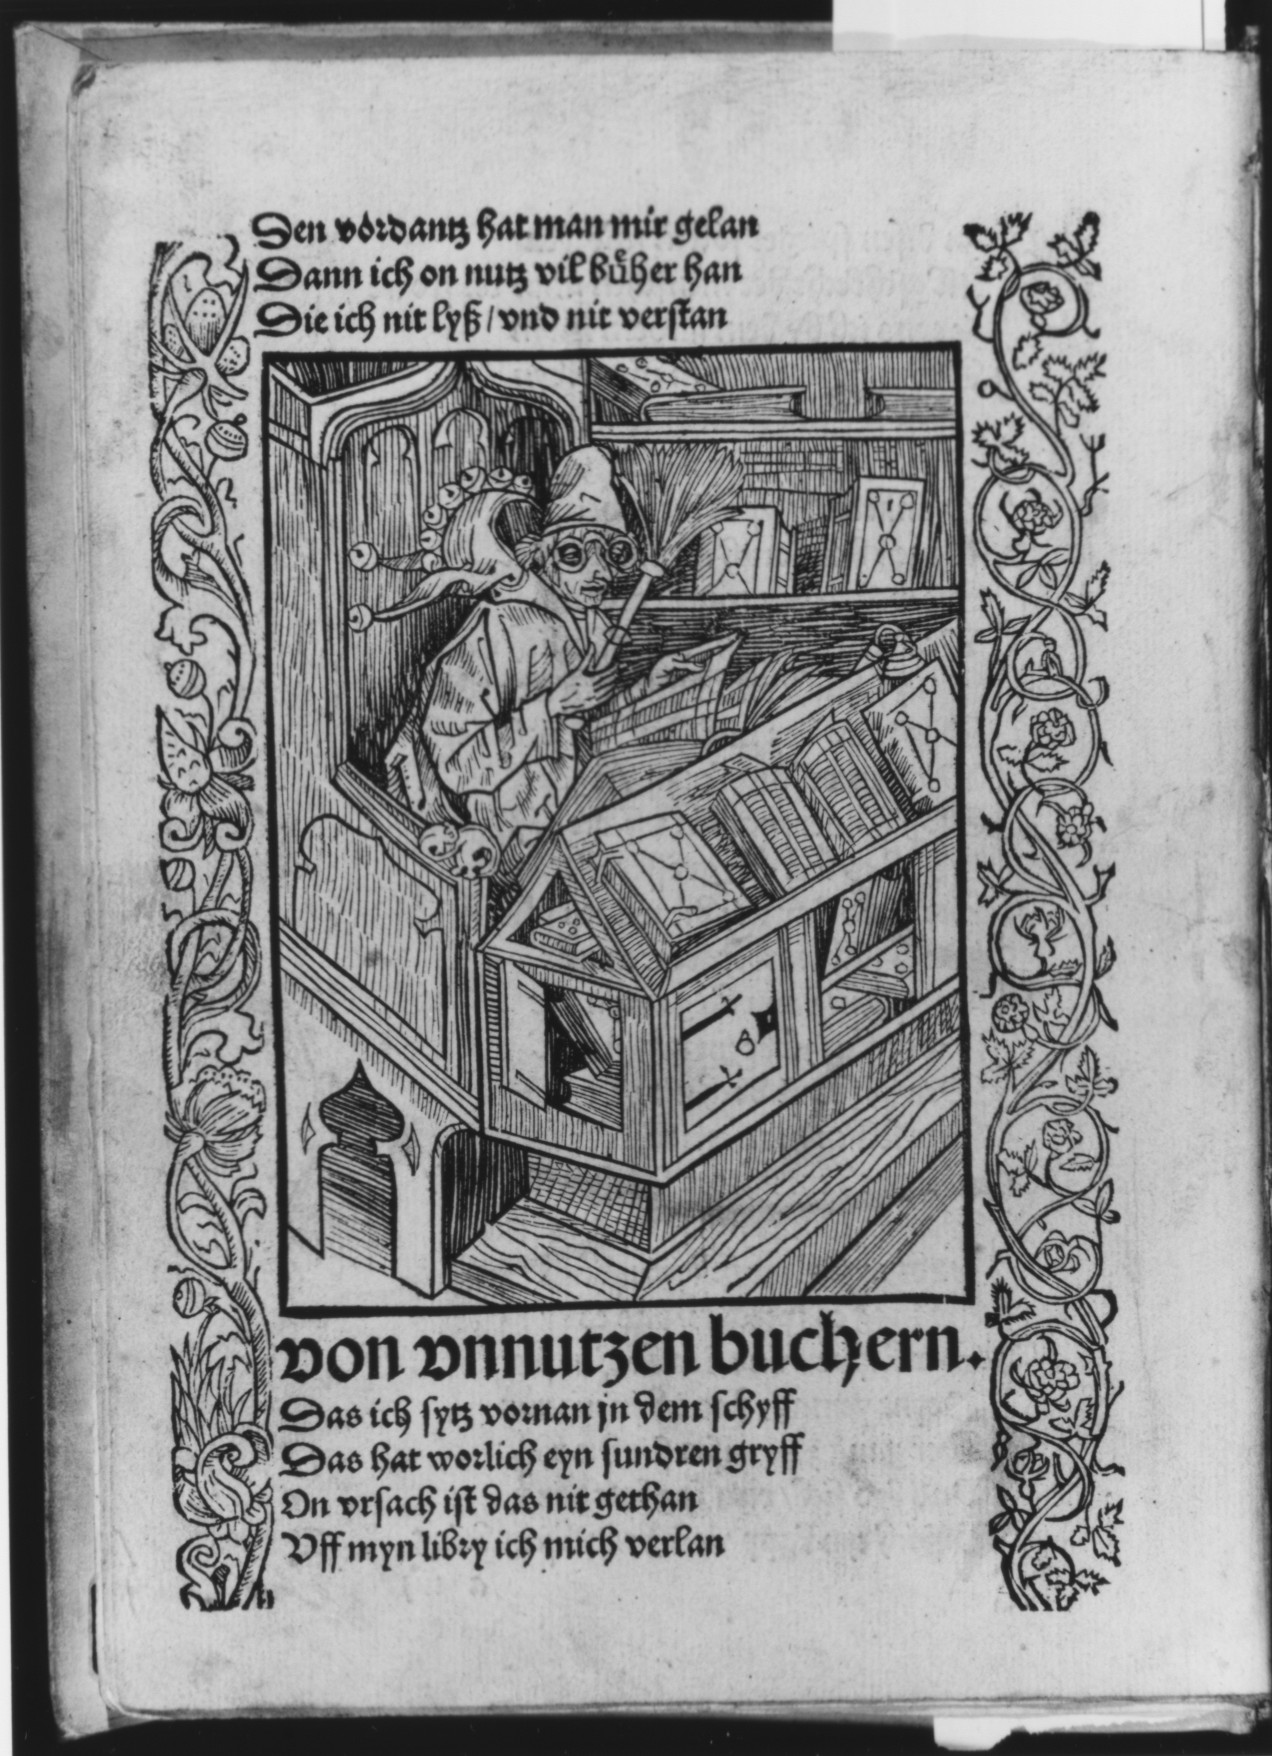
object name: book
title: Das Narrenschyff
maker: albrecht dürer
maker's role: artist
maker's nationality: german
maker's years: 1471-1528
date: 1495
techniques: woodcut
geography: switzerland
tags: books,men,furniture